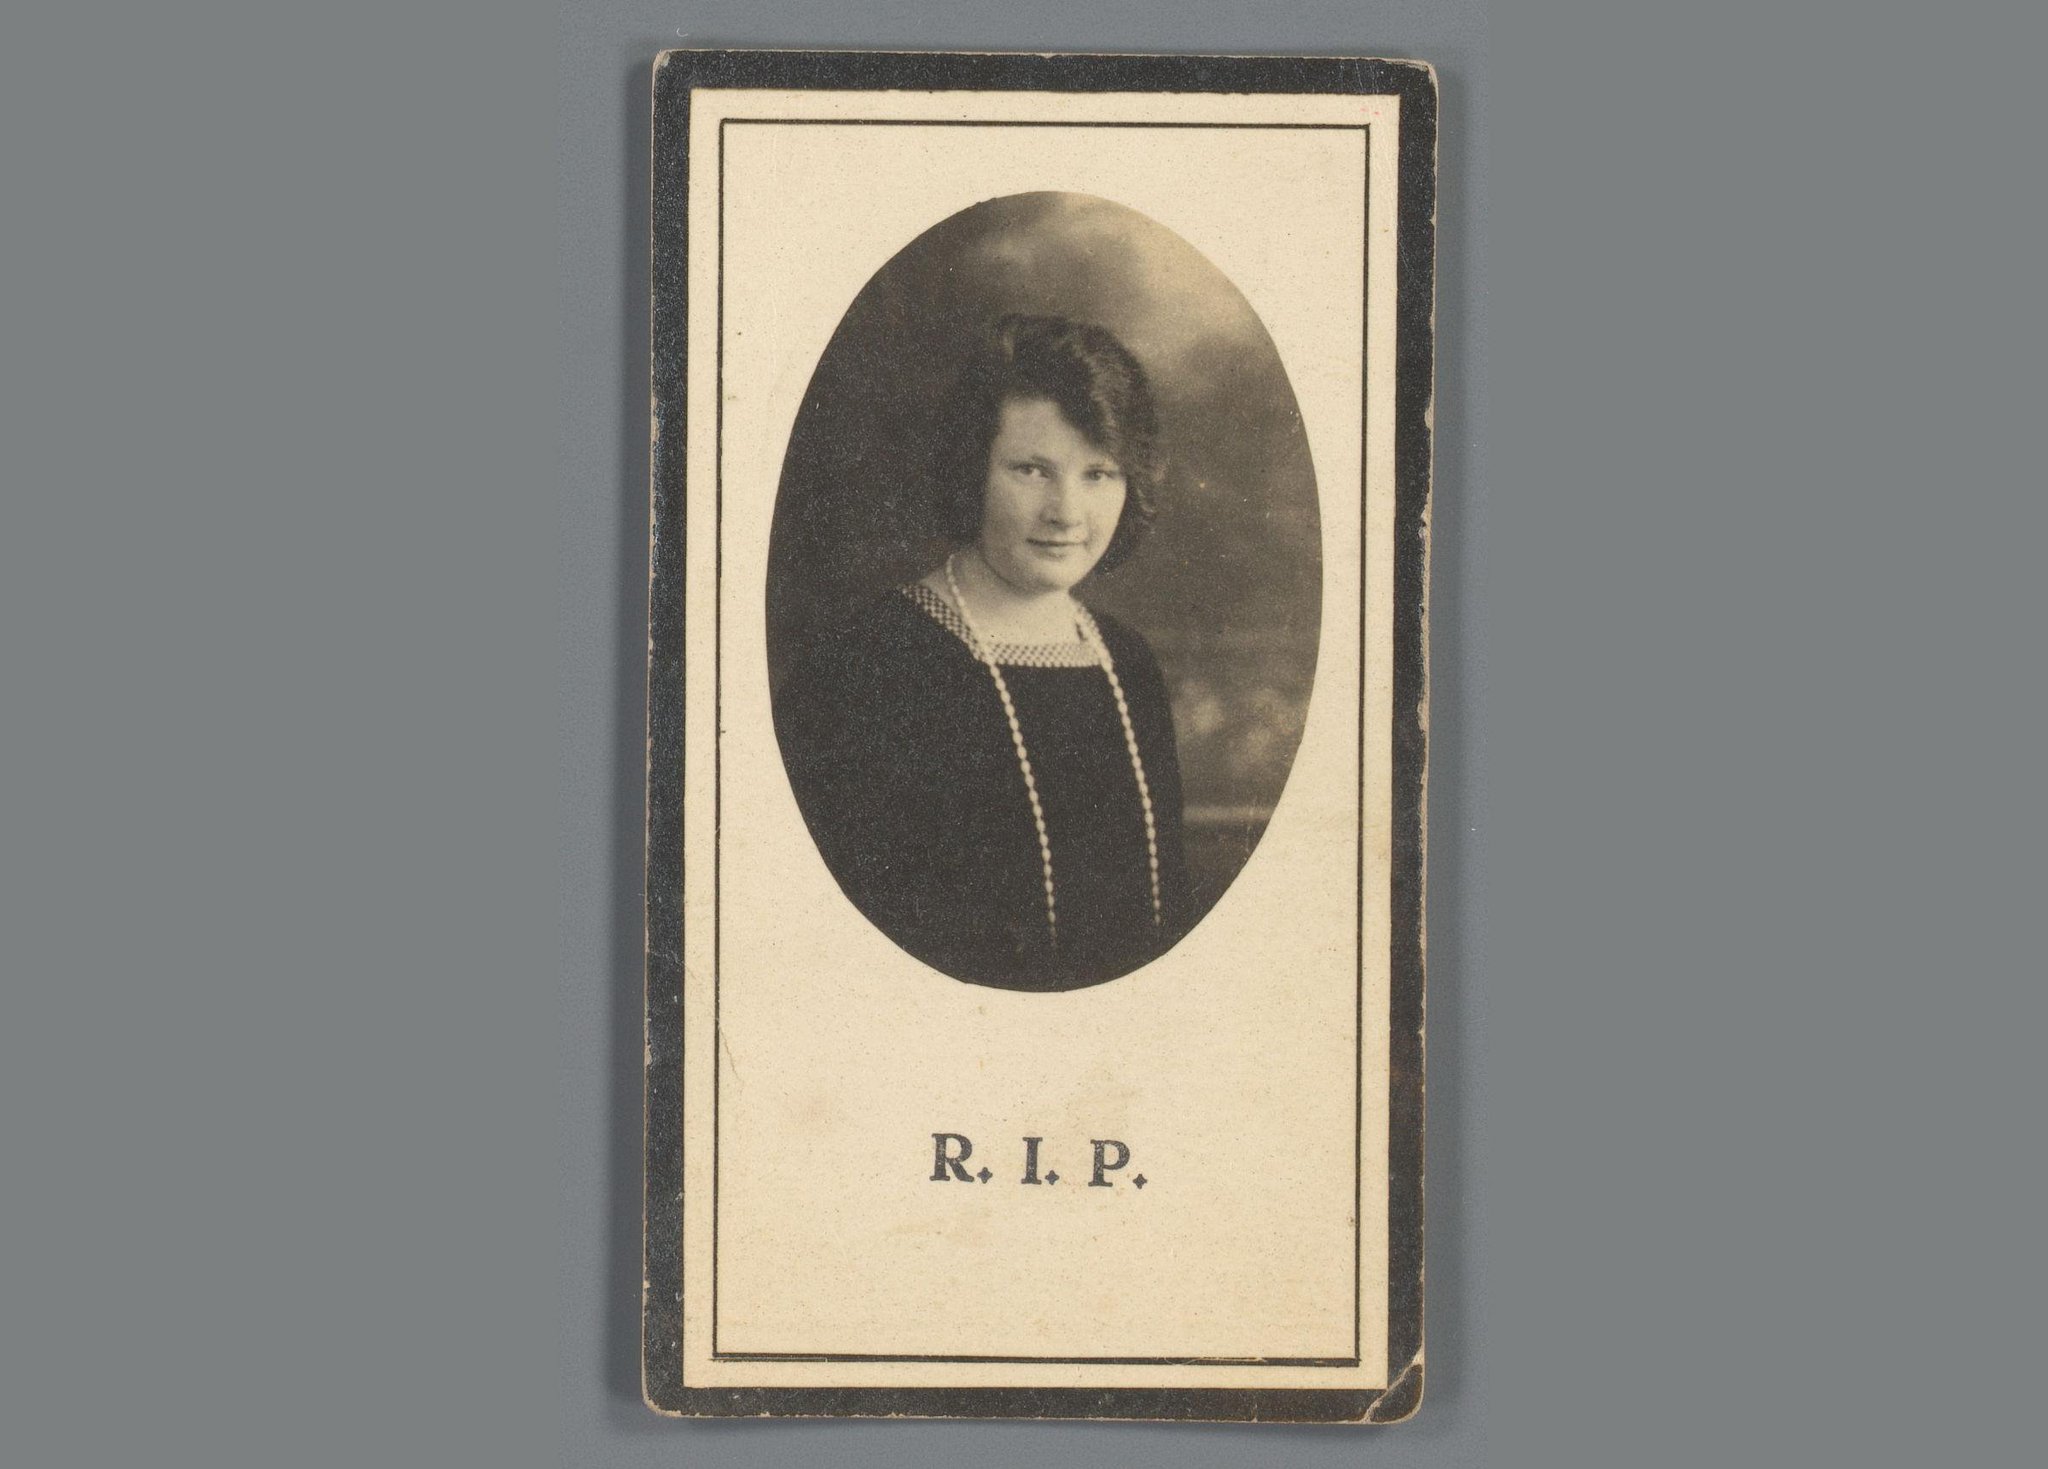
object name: photograph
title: Portret van Martha Schouten op bidprent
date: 1926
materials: paper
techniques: gelatin silver print, letterpress printing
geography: westerblokker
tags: adolescent, young woman, maiden, historical persons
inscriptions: inscription: ‘Bid voor/ de ziel van zaliger (...) ruste in vrede. Amen./ P. Karsten - Westerblokker.’